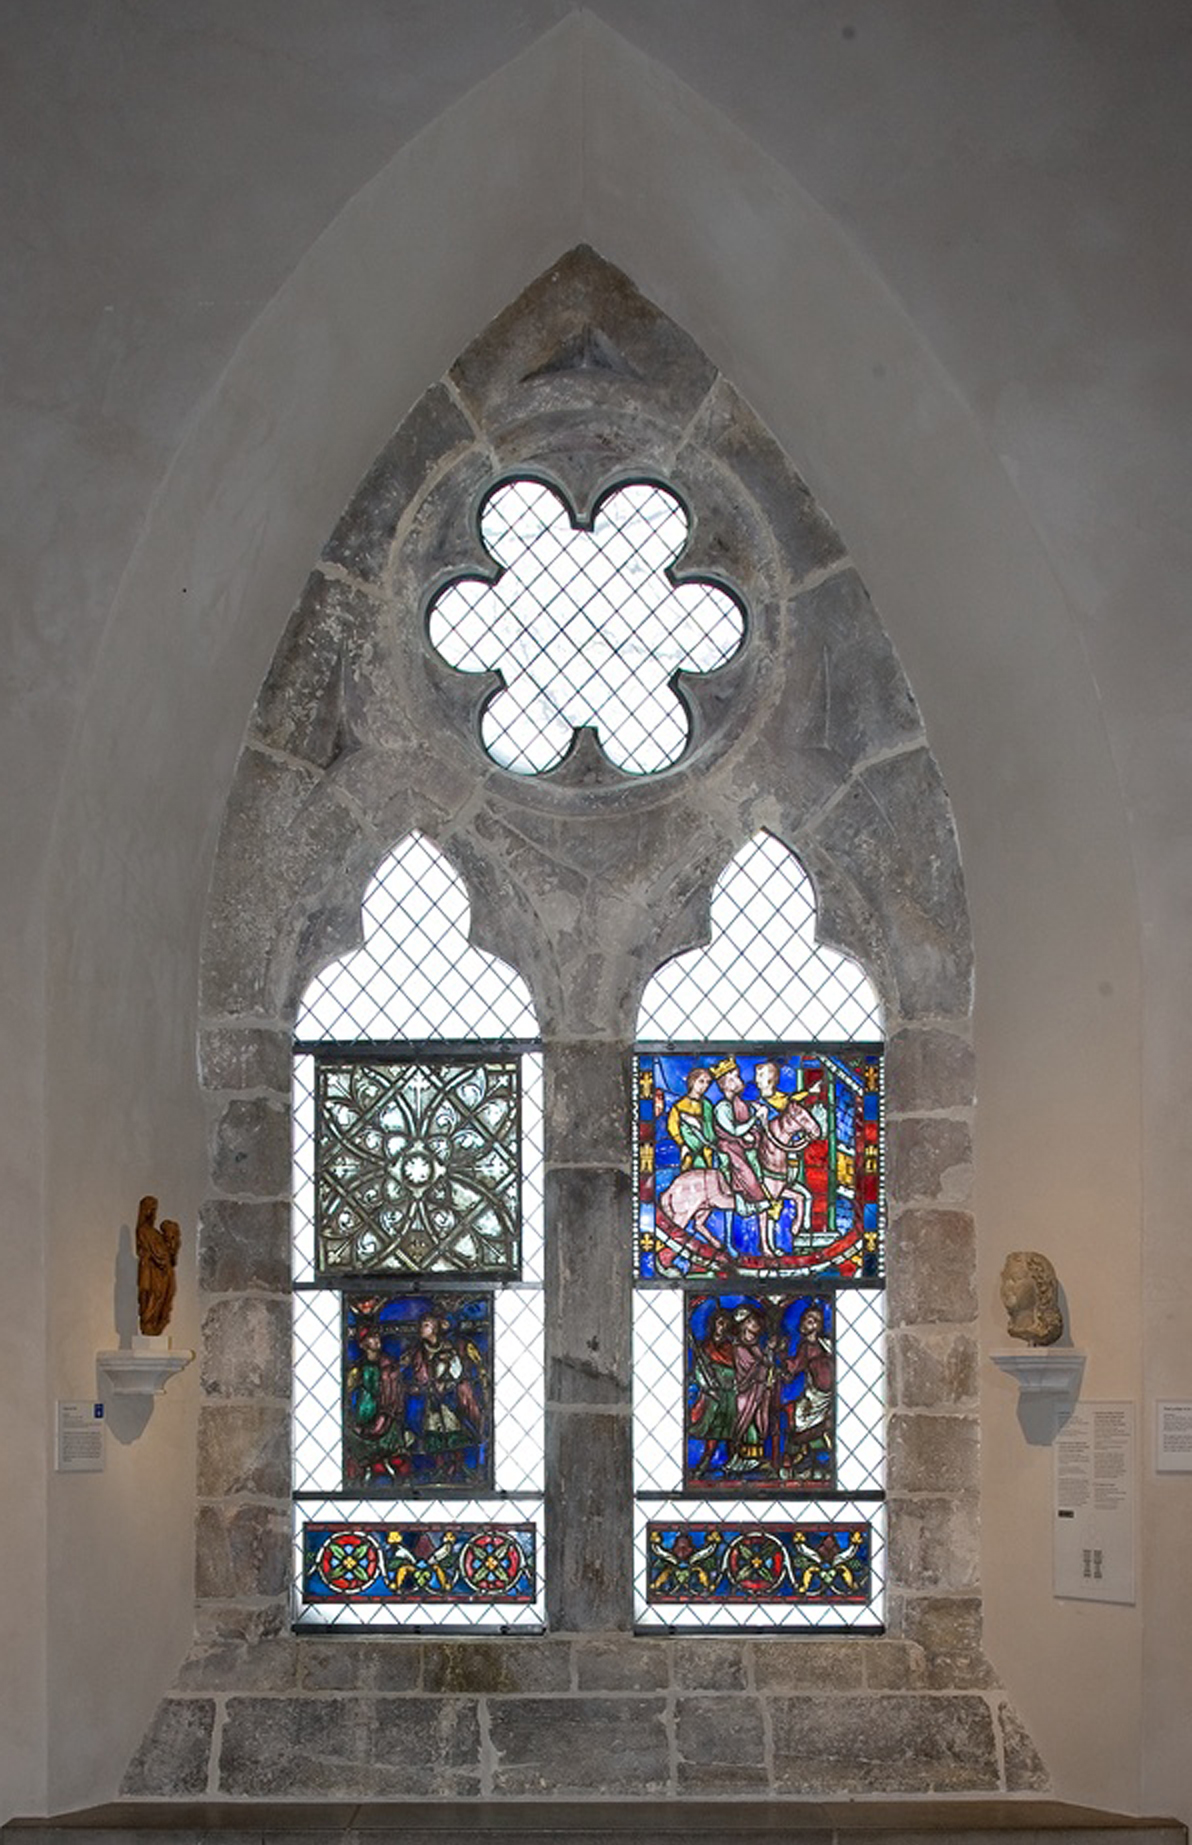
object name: window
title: Lancet Window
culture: french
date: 1250-1300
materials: limestone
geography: france